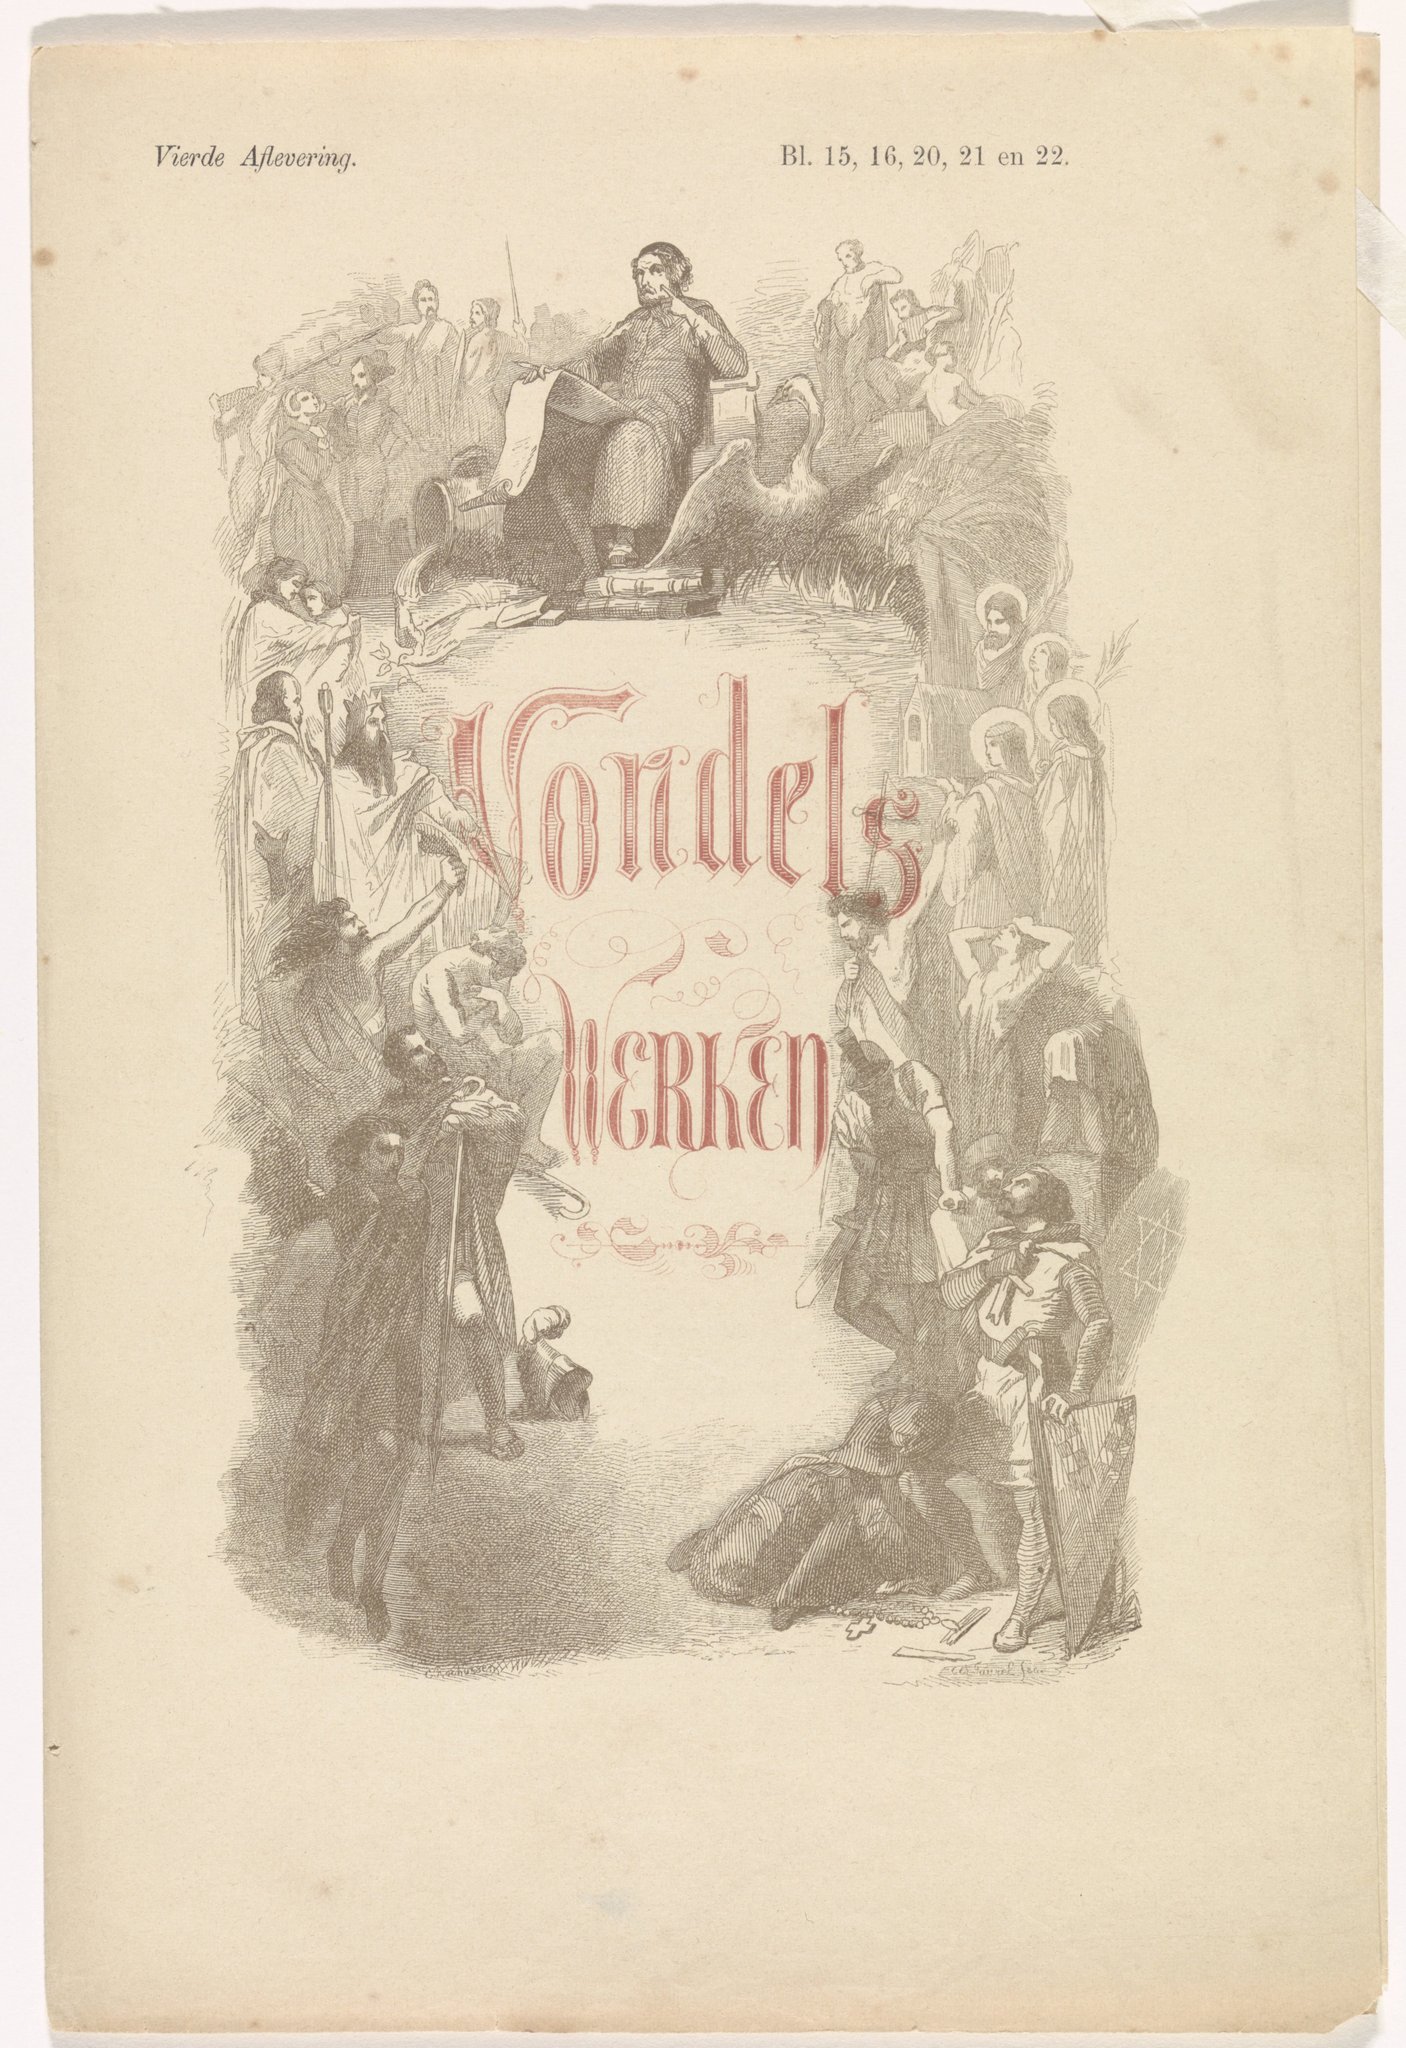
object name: print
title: Vondels Werken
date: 1855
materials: paper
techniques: engraving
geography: amsterdam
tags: amsterdam, joost van den vondel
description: Brericht en voorwaarden voor intekening voor: De werken van Vondel in verband gebracht met zijn leven, en voorzien van verklaring en aanteekeningen door Mr. J. van Lennep. Vierde aflevering. Amsterdam: M.H. Binger en zn., 1855.